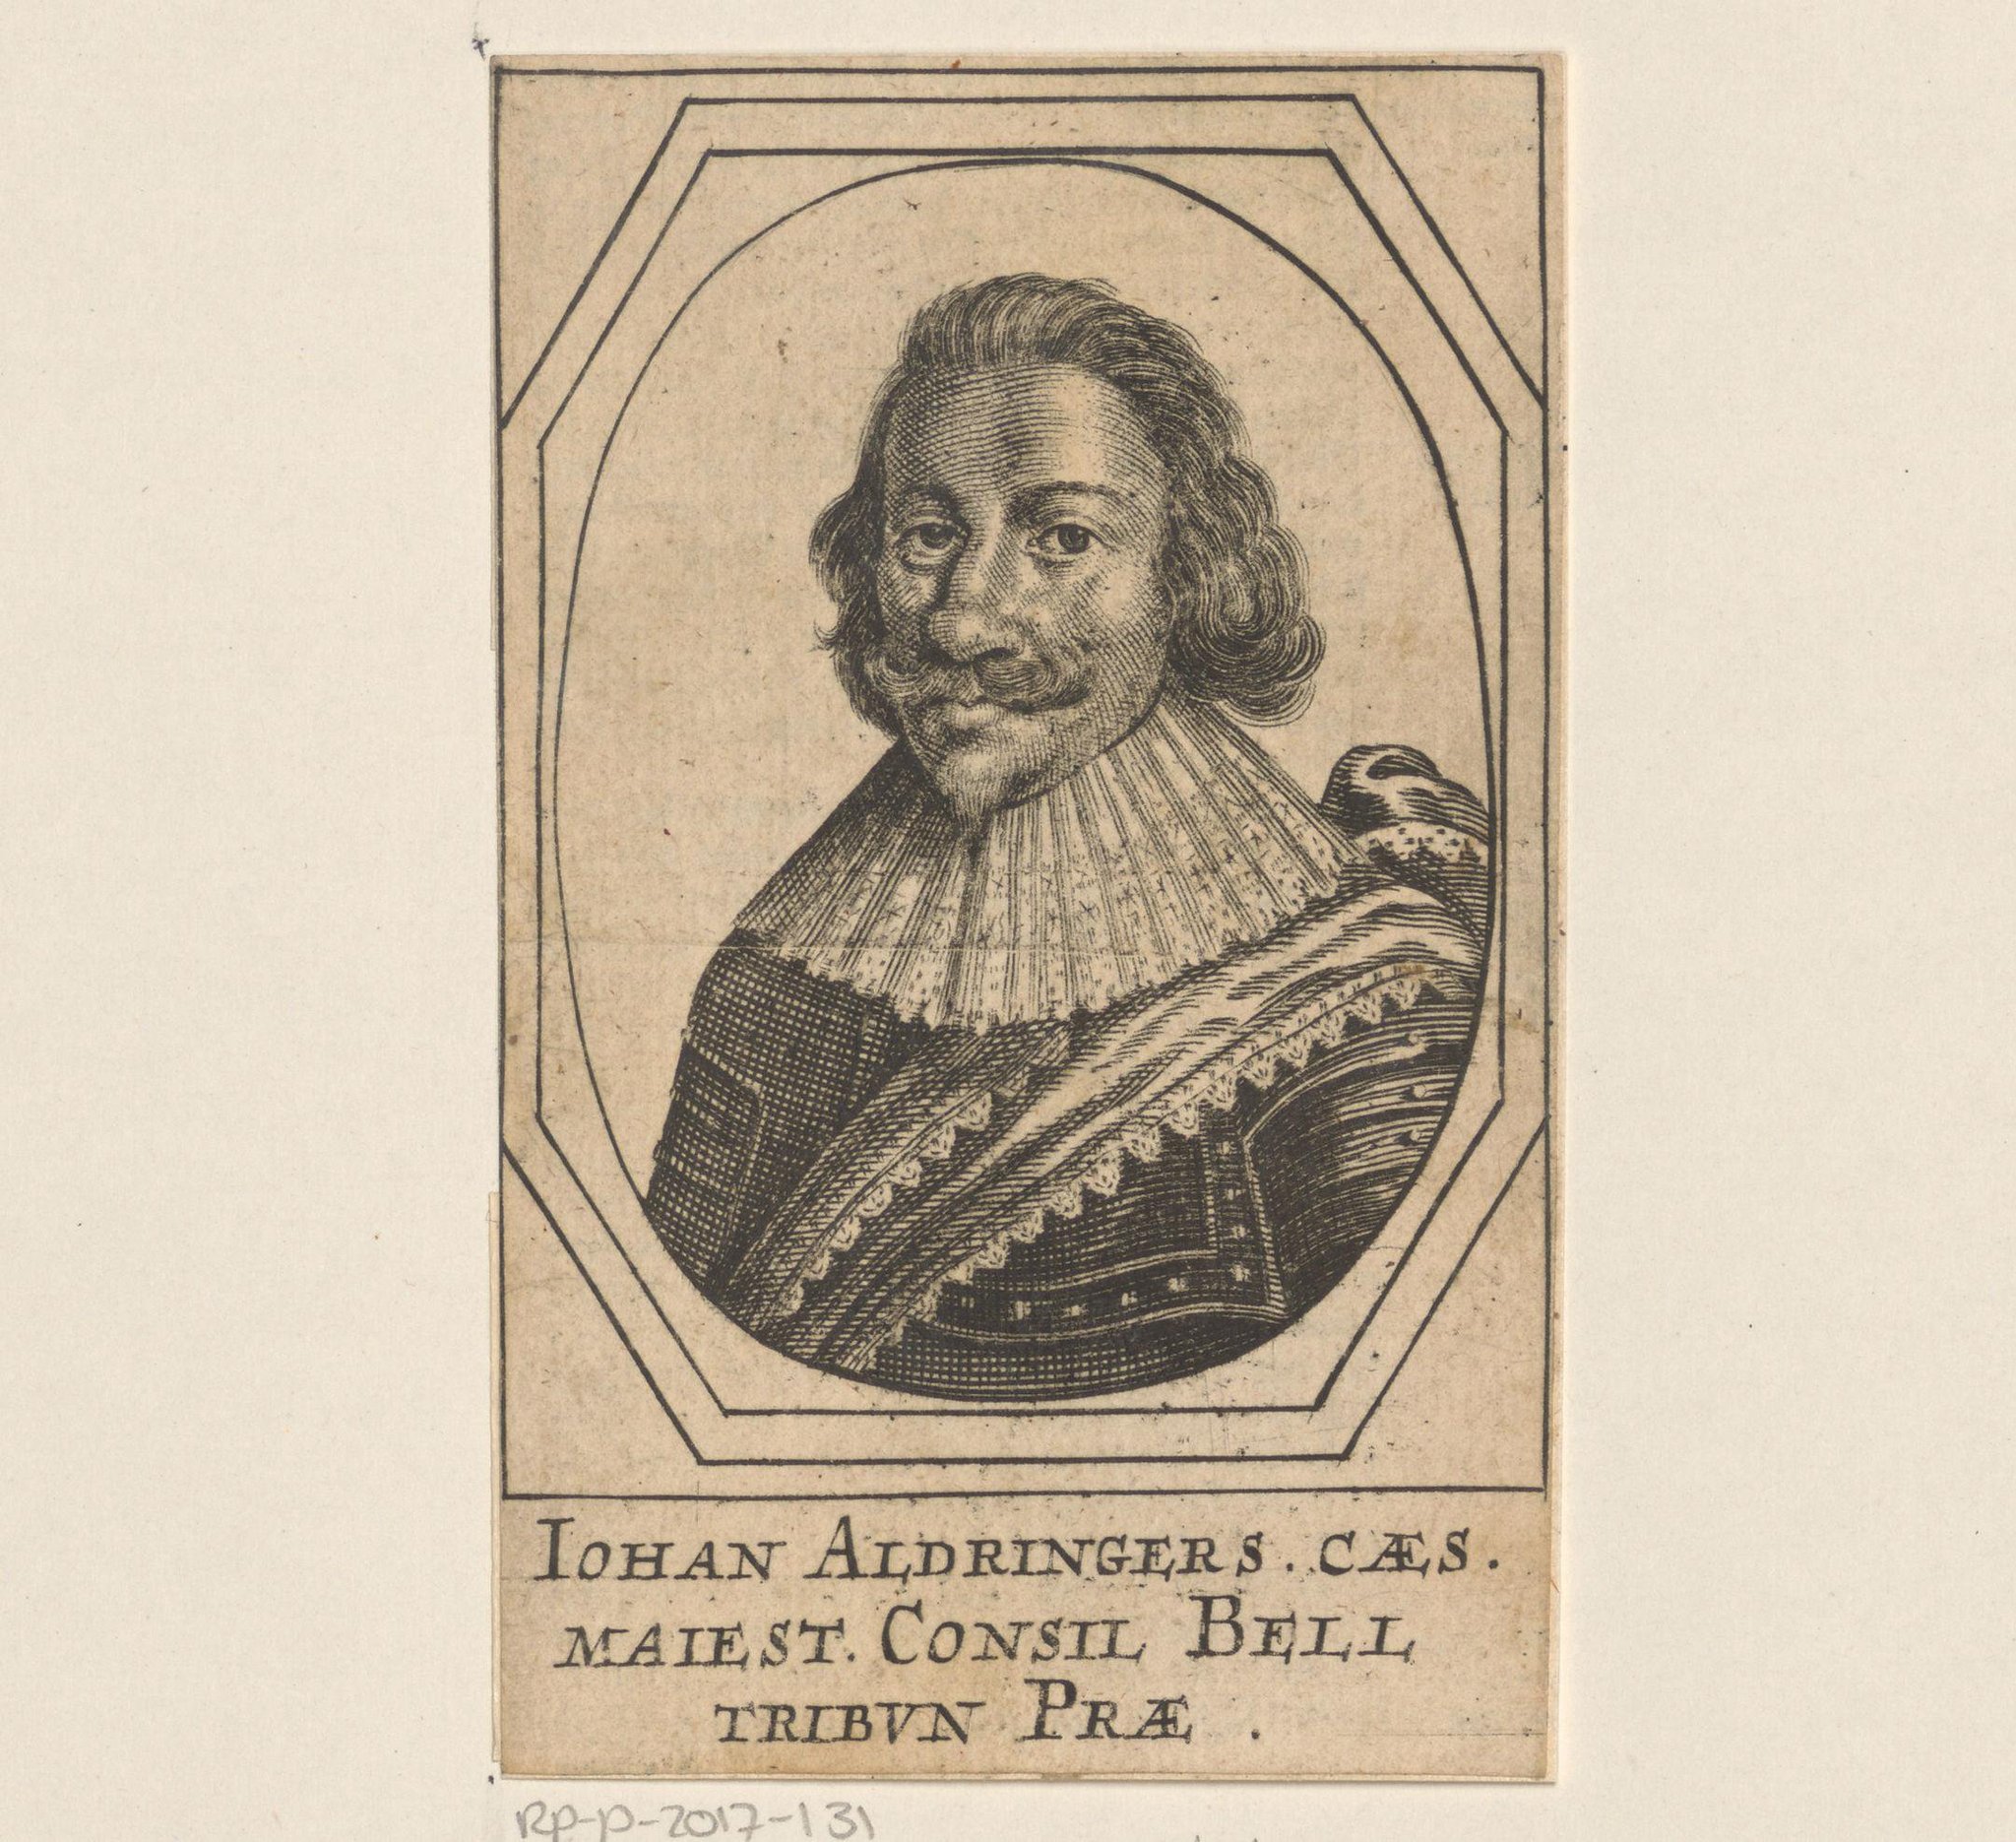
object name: print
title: Portret van Johann, graaf van Aldringen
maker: Anonymous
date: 1650-1749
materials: paper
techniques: engraving, etching, letterpress printing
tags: thionville, landshut, bevelhebber, johann rijksgraaf van aldringen